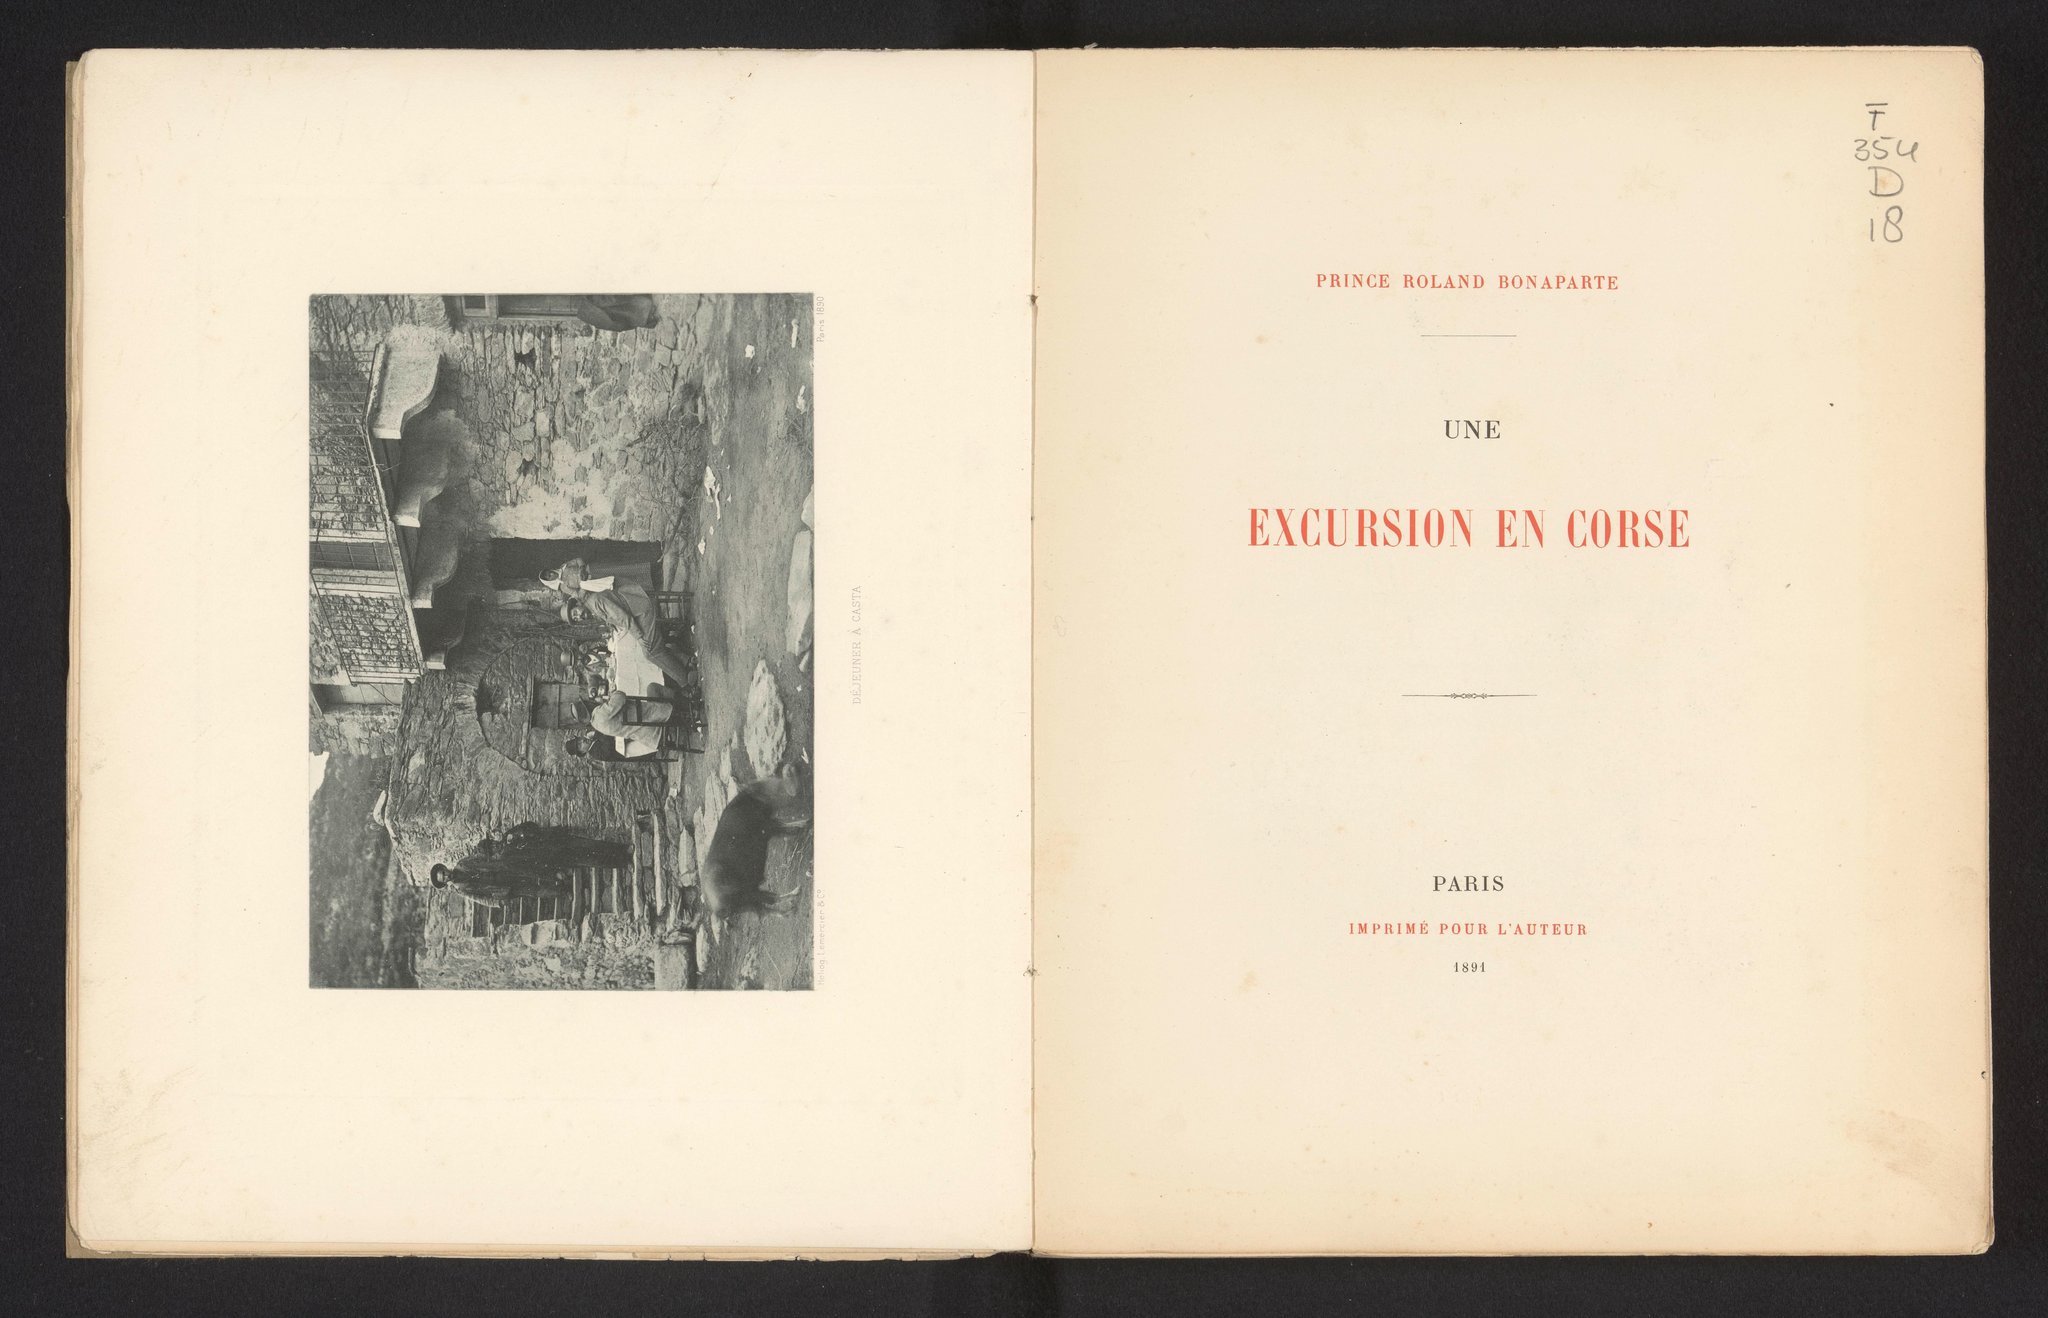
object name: page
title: Déjeuner à Casta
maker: roland napoleon bonaparte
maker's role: botanicus, fotograaf, geograaf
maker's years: 1858-1924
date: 1881-1890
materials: paper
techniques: photoaquatint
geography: corsica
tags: pig, breakfast - cc - out of doors, street